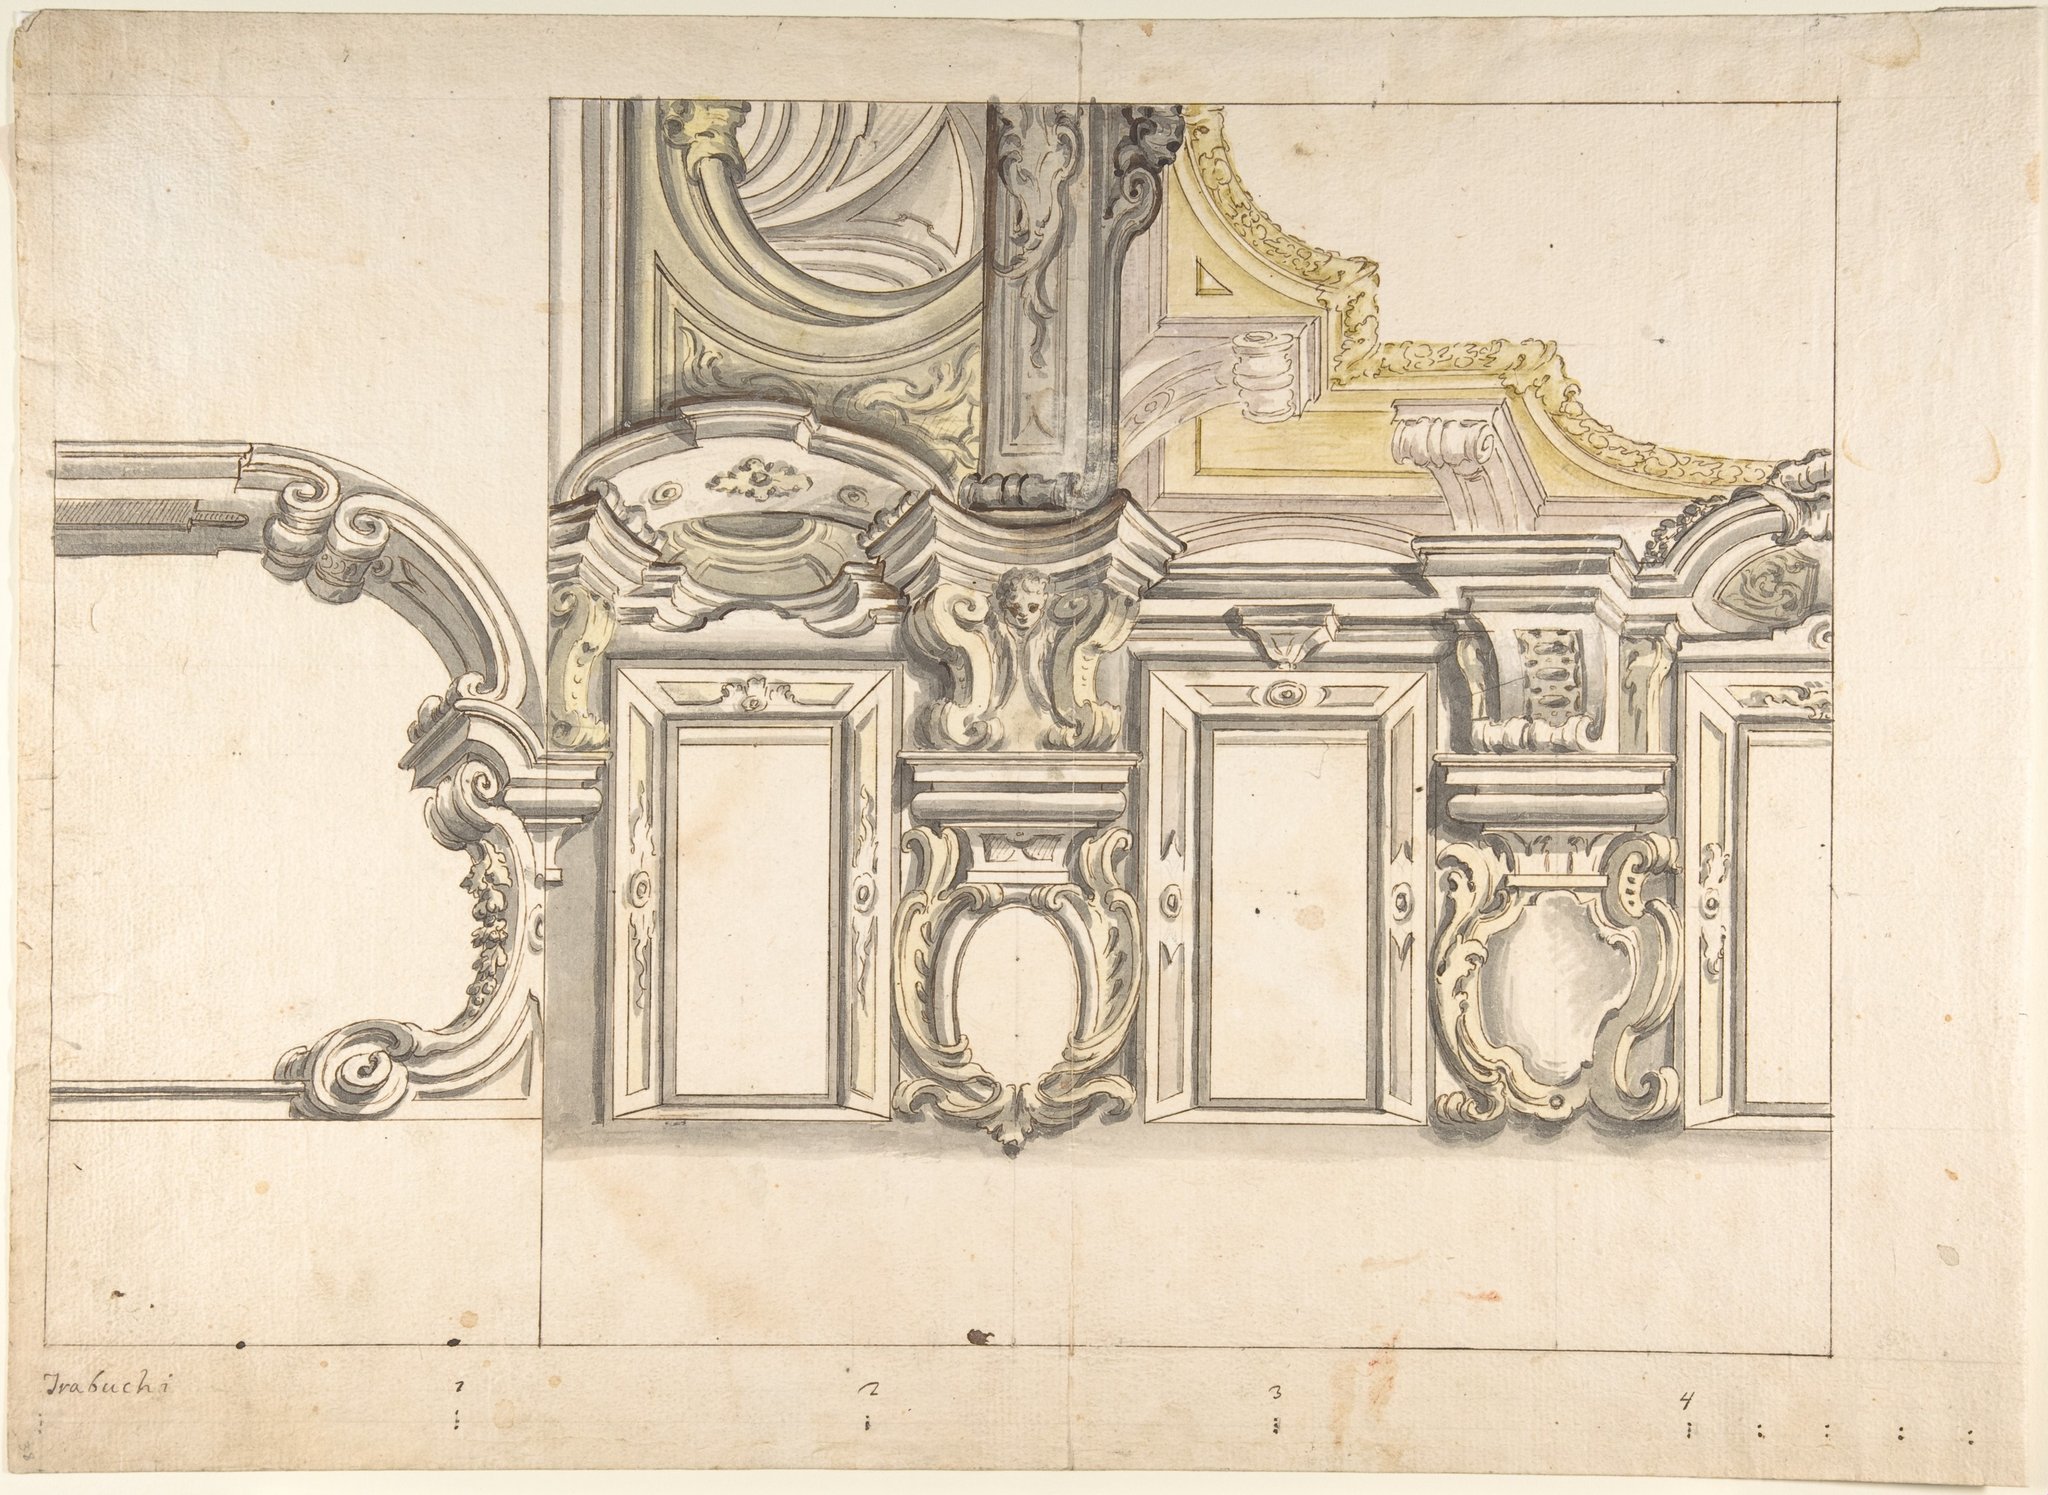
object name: drawing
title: Design for an Attic Window and an Interior, with the Frame of the Ceiling Shown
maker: anonymous, italian, piedmontese, 18th century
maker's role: artist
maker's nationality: italian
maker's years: 1700-1800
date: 1700-1780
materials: graphite, ink, drawing material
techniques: brush, pen, wash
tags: architecture